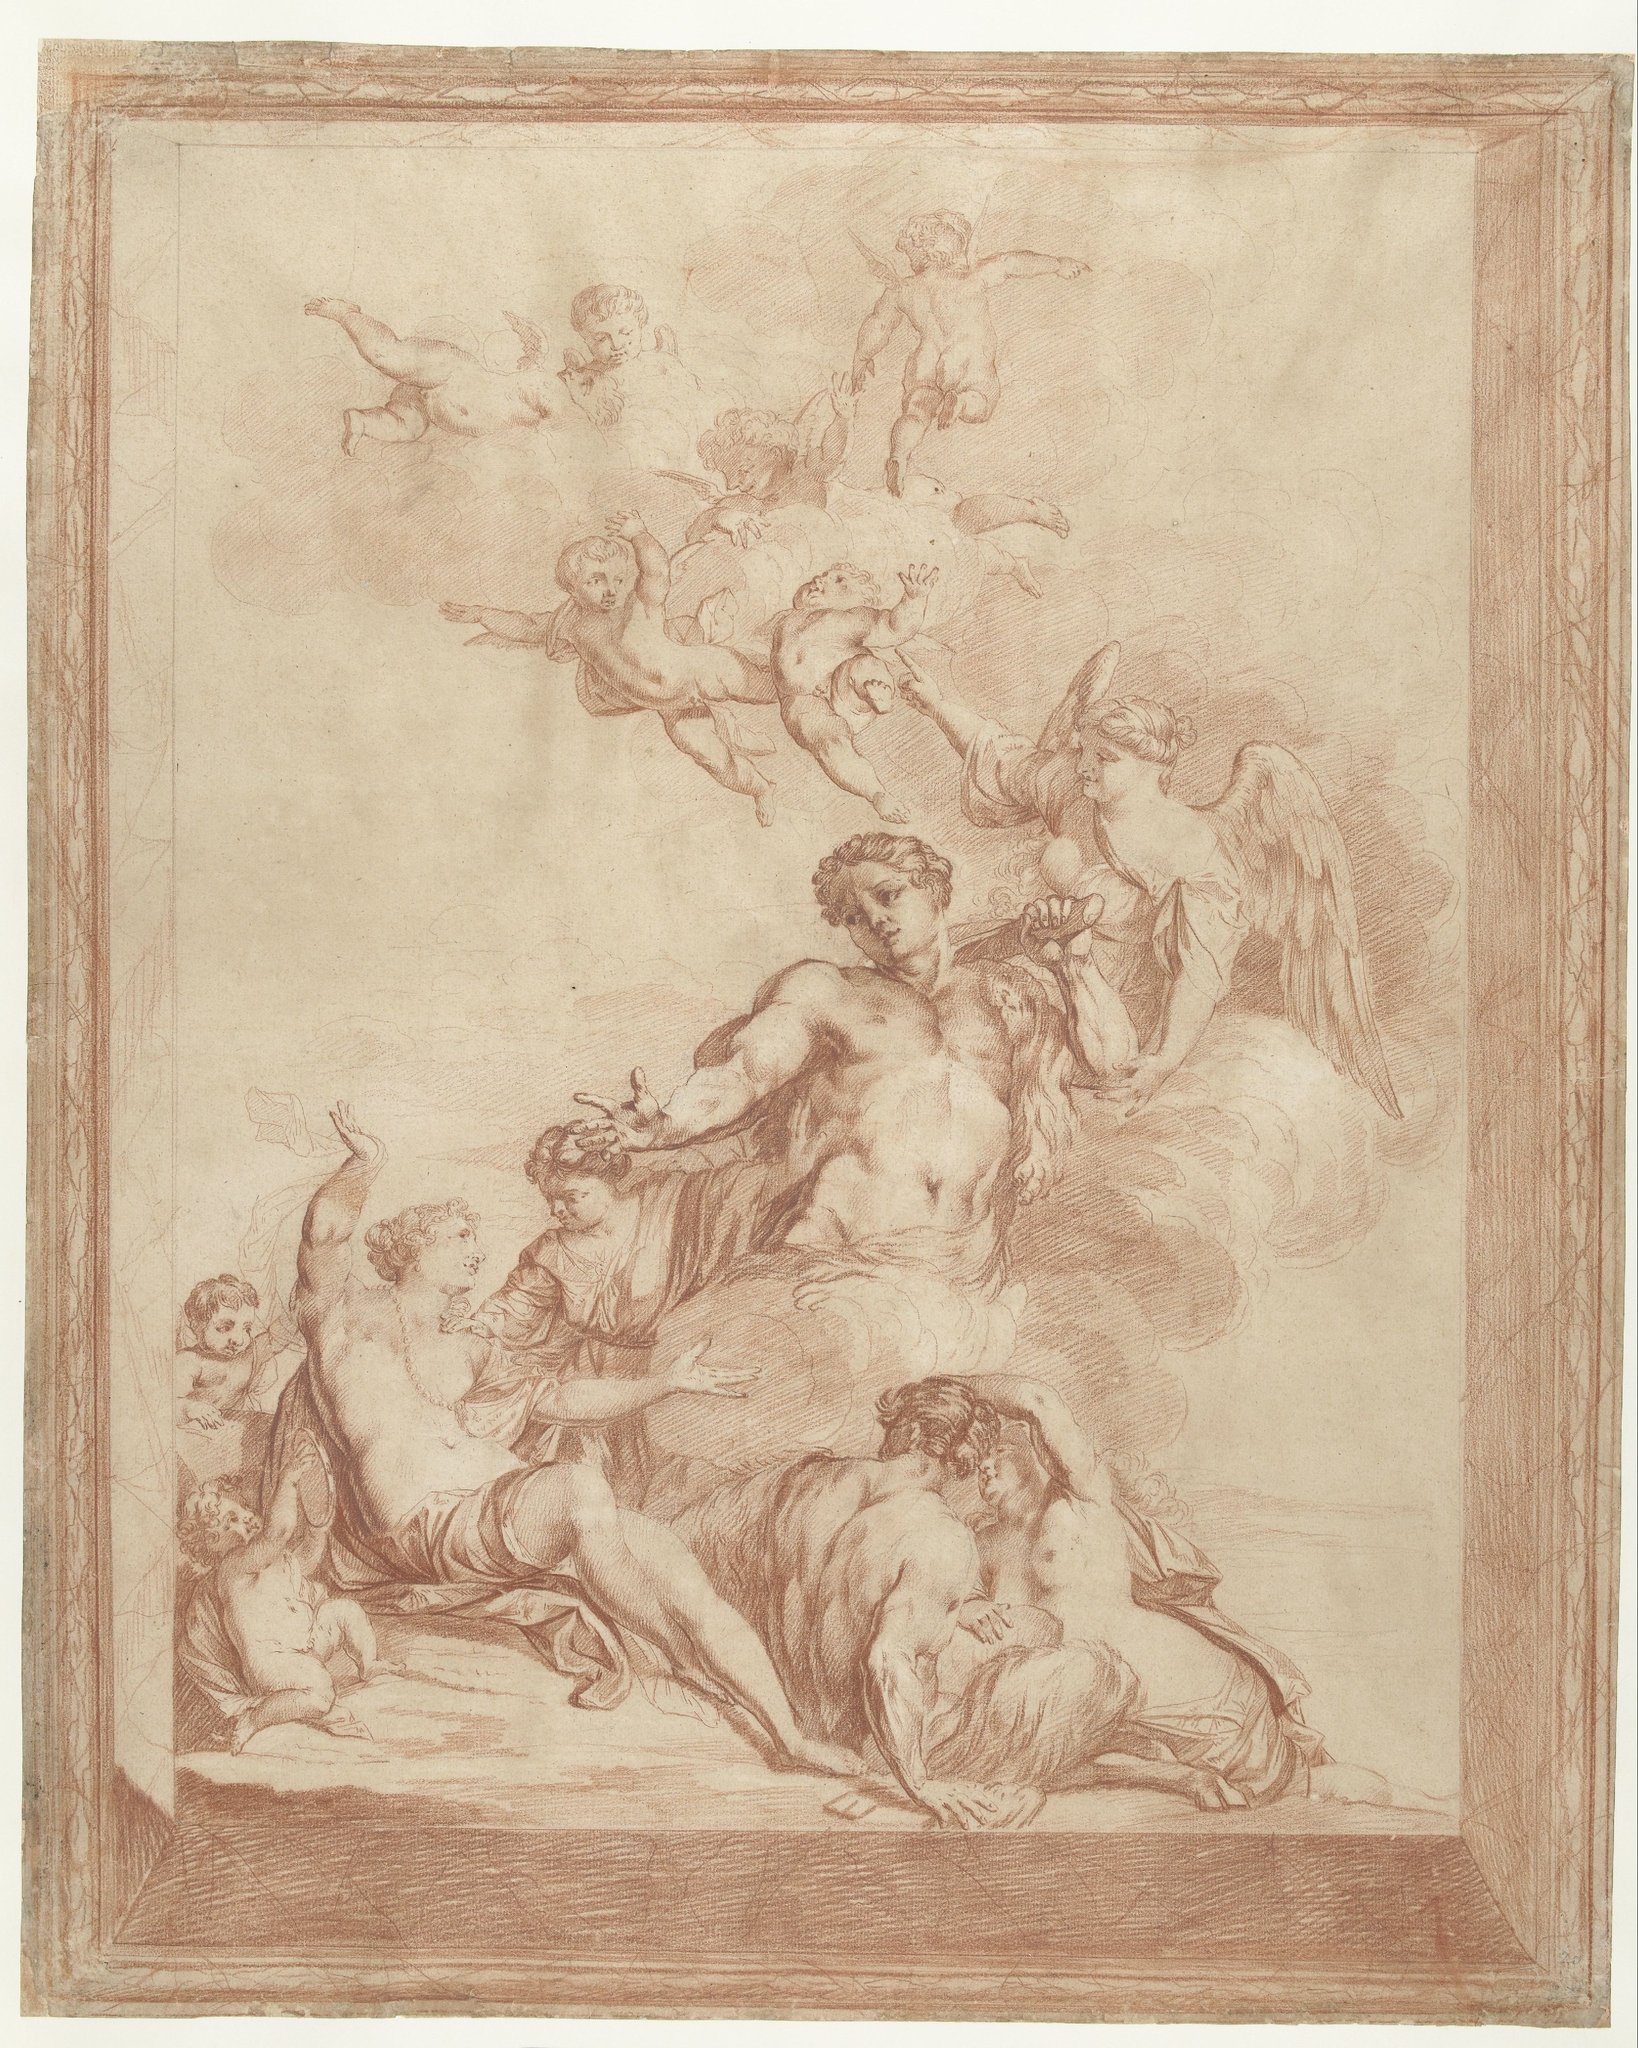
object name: drawing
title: Hercules op de tweesprong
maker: mattheus terwesten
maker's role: draughtsman, painter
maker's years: 1670-1757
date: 1680-1757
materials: chalk, paper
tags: hercules at the cross-roads, 'herkules am scheidewege': the choice of hercules